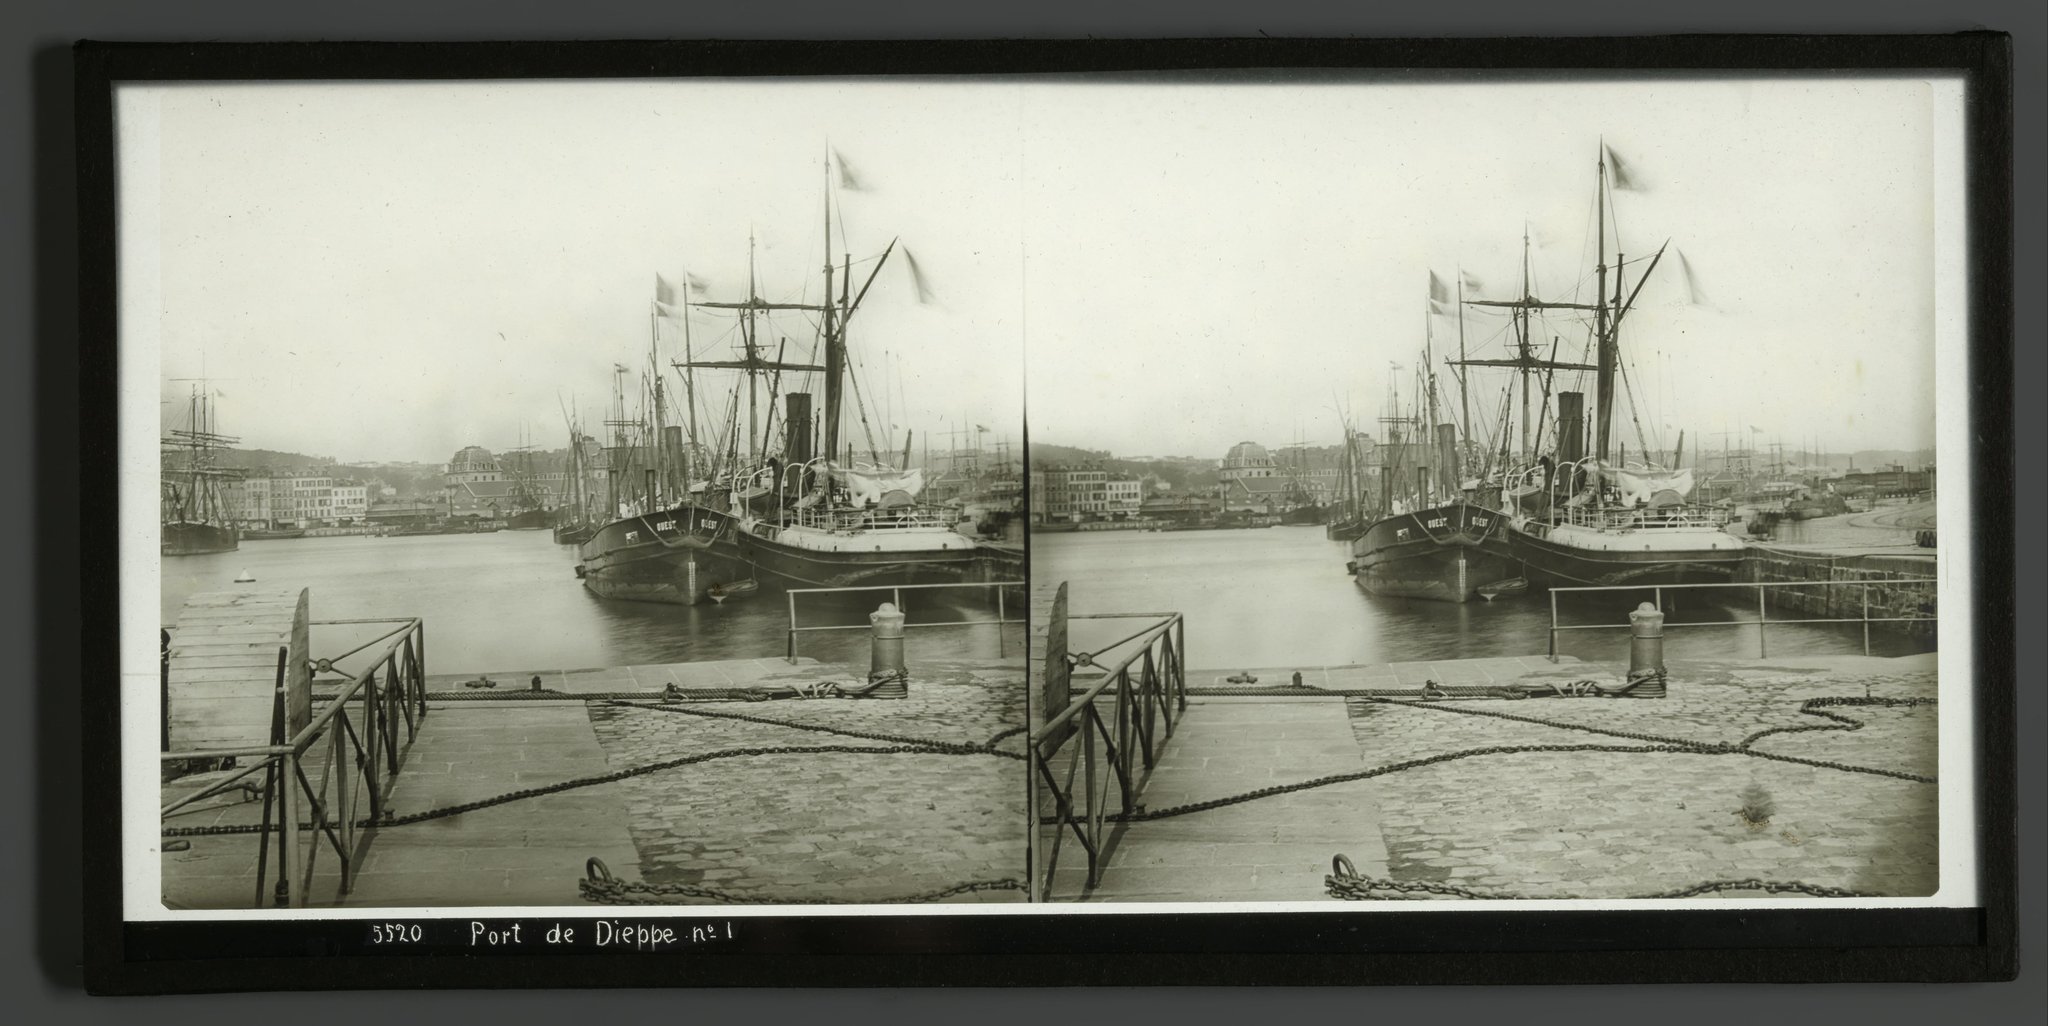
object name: stereoscopic photograph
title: Port de Dieppe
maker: Anonymous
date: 1860-1890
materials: glass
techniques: slide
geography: dieppe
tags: harbour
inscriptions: number: ‘5520/ No 1’